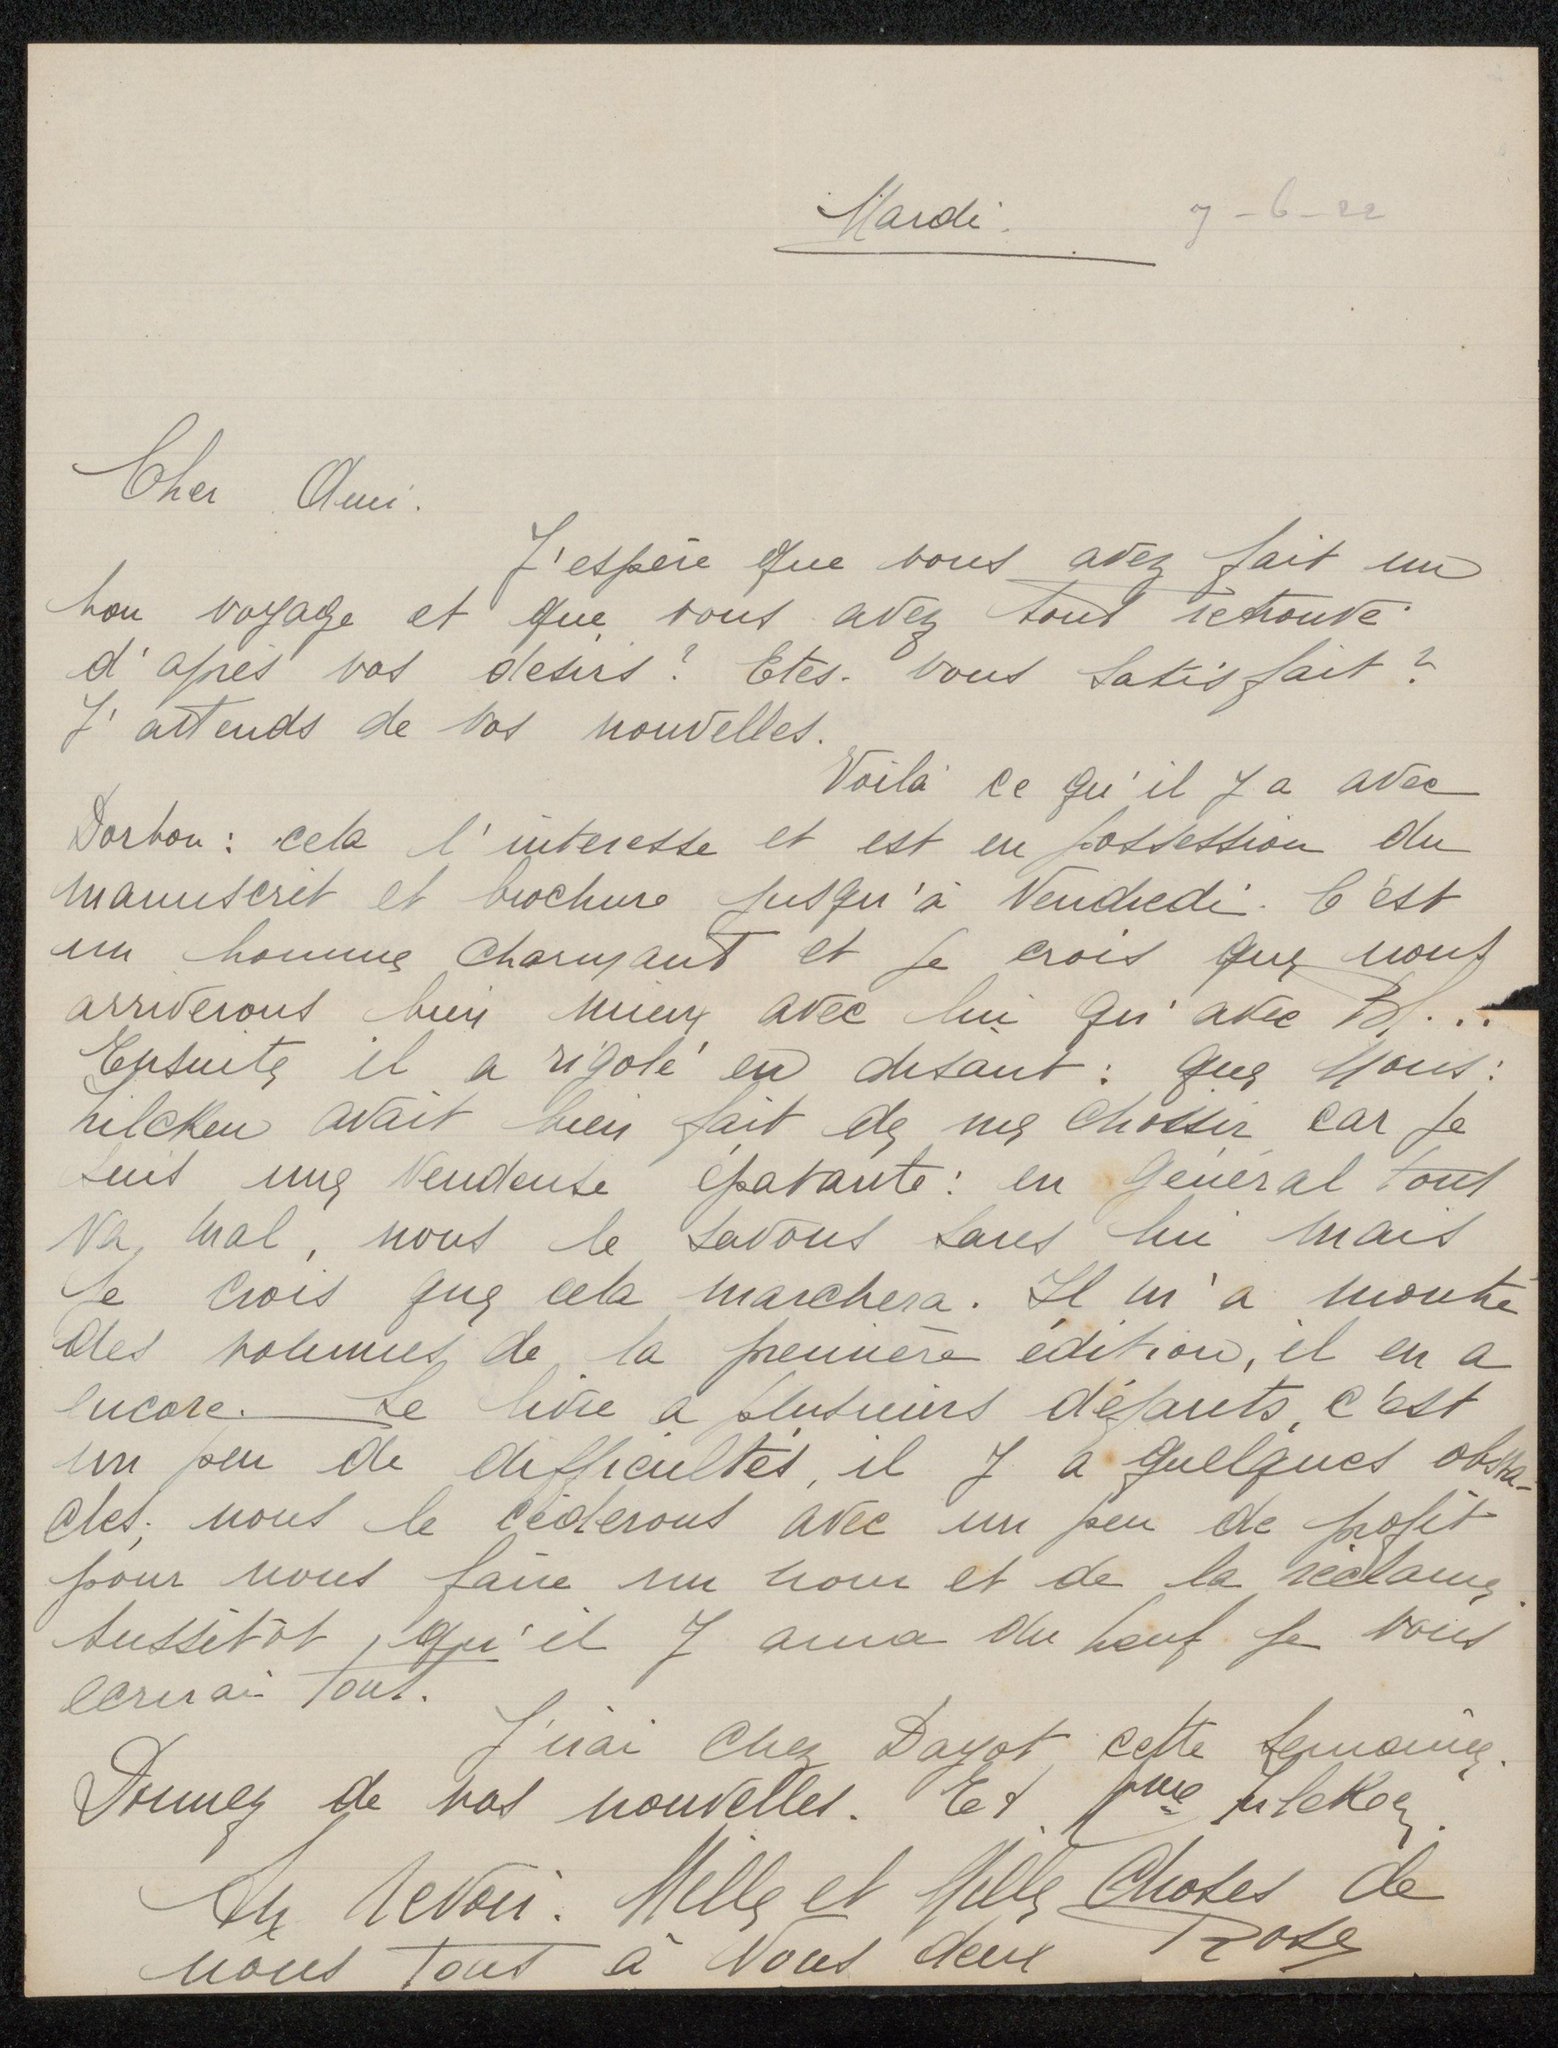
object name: letter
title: Brief aan Philip Zilcken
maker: rose imel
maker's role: draughtsman, painter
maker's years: 1901-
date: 1911-1930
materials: ink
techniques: pen, writing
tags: the hague, painter, philip zilcken, printed matter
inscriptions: collector's mark: ‘RPK’, watermark